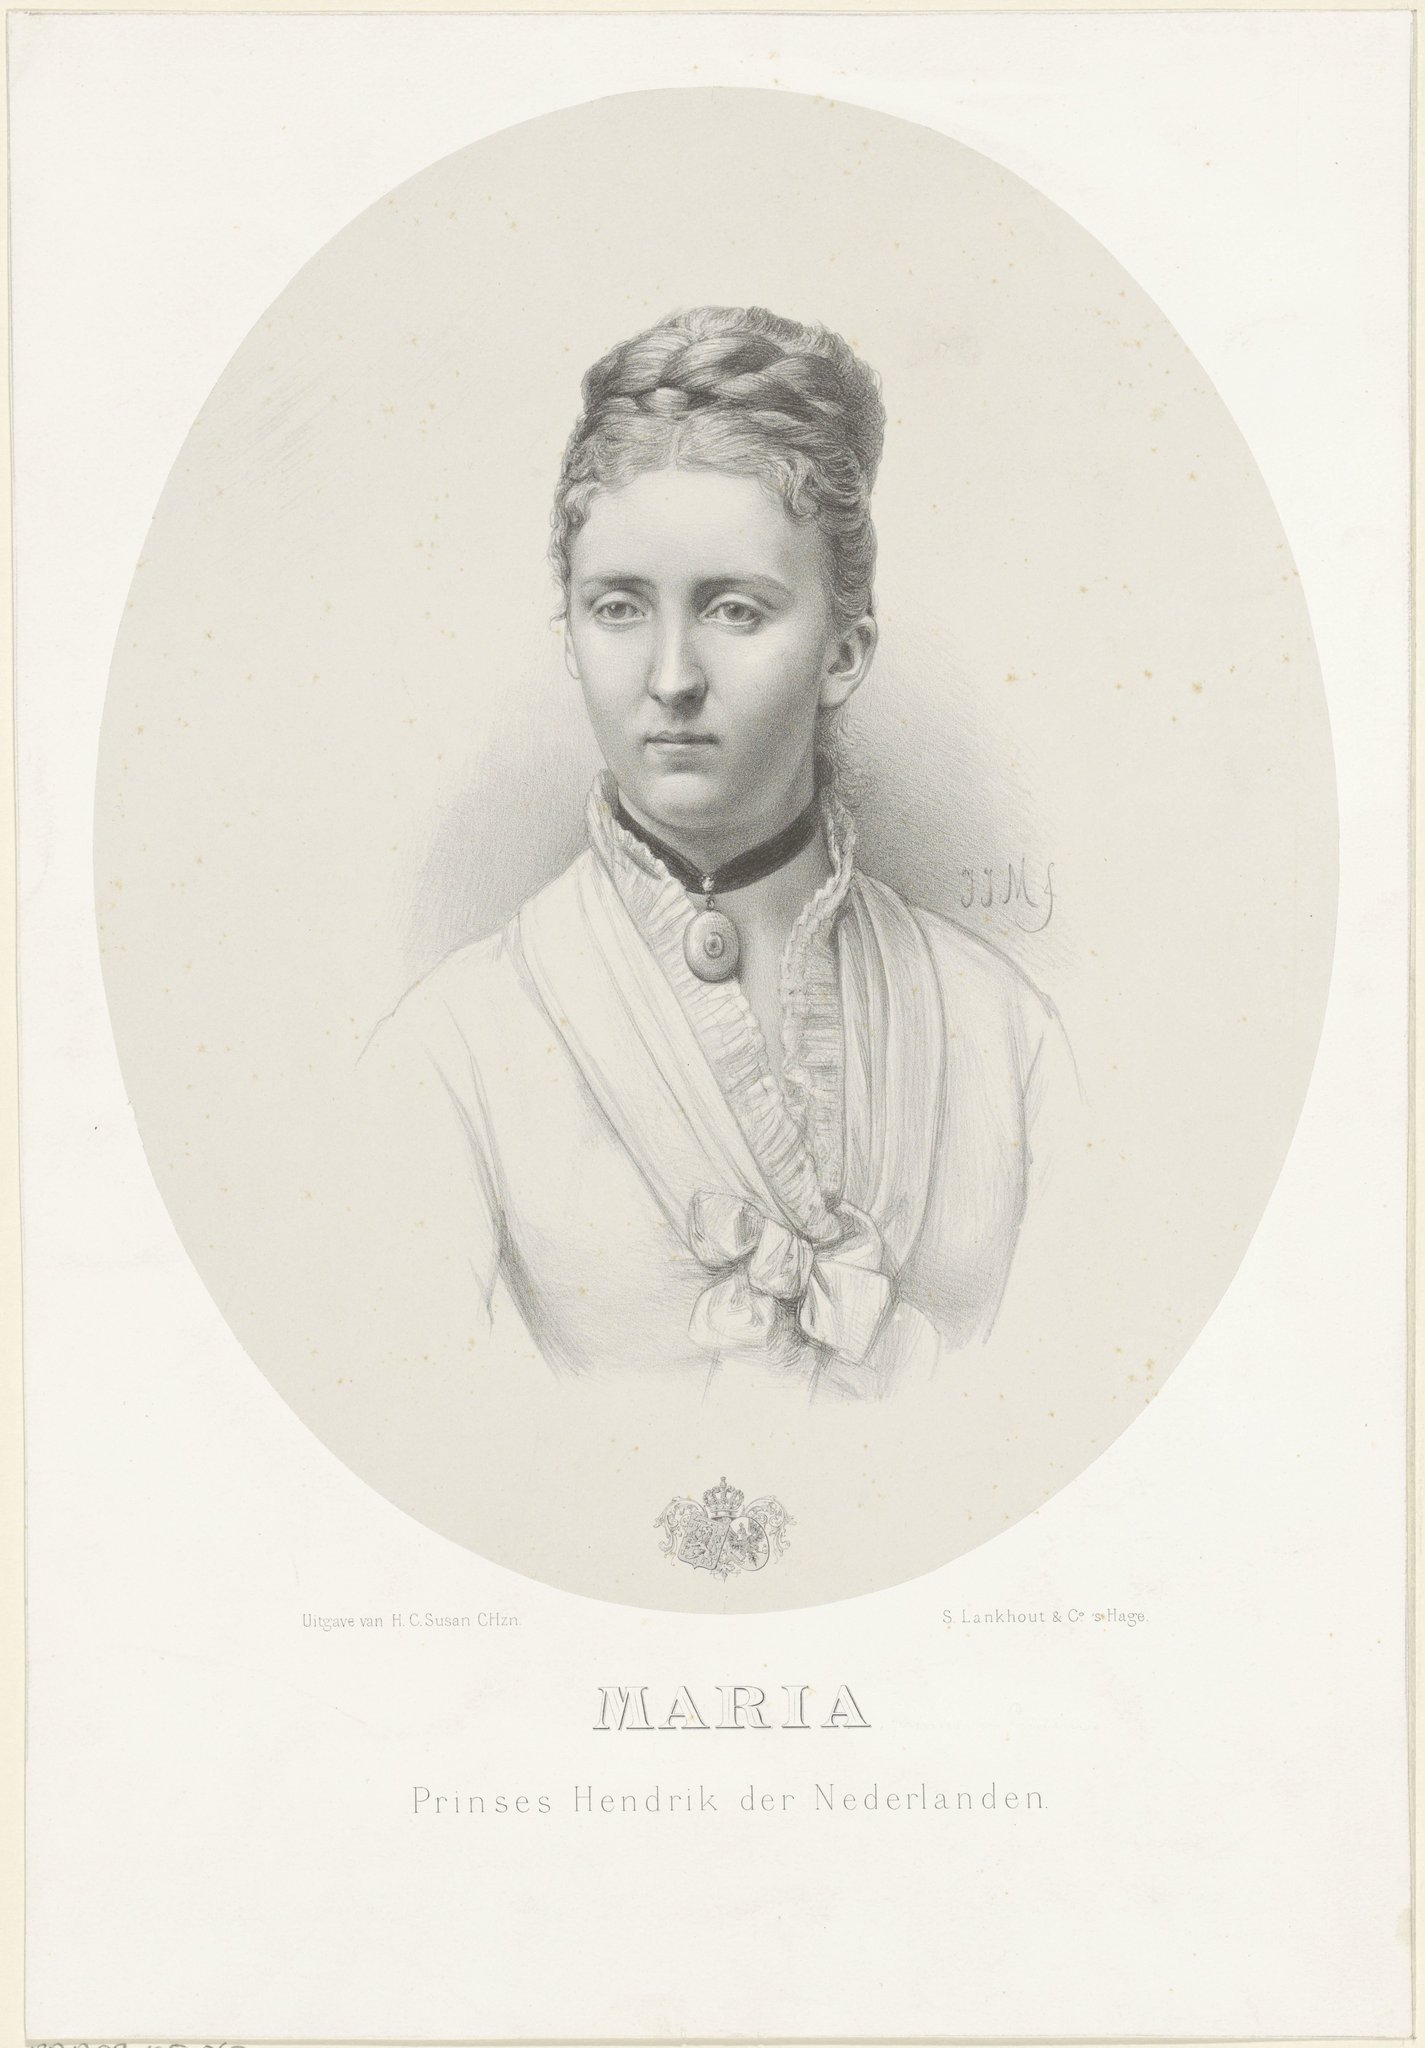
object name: print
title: Portret van Maria van Pruisen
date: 1877-1903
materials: paper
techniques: lithograph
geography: the hague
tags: hendrik (prins der nederlanden)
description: Portret van Maria van Pruisen in een ovaal. Midden onder haar wapen en het wapen van Hendrik met een kroon. In de ondermarge haar naam en titel.